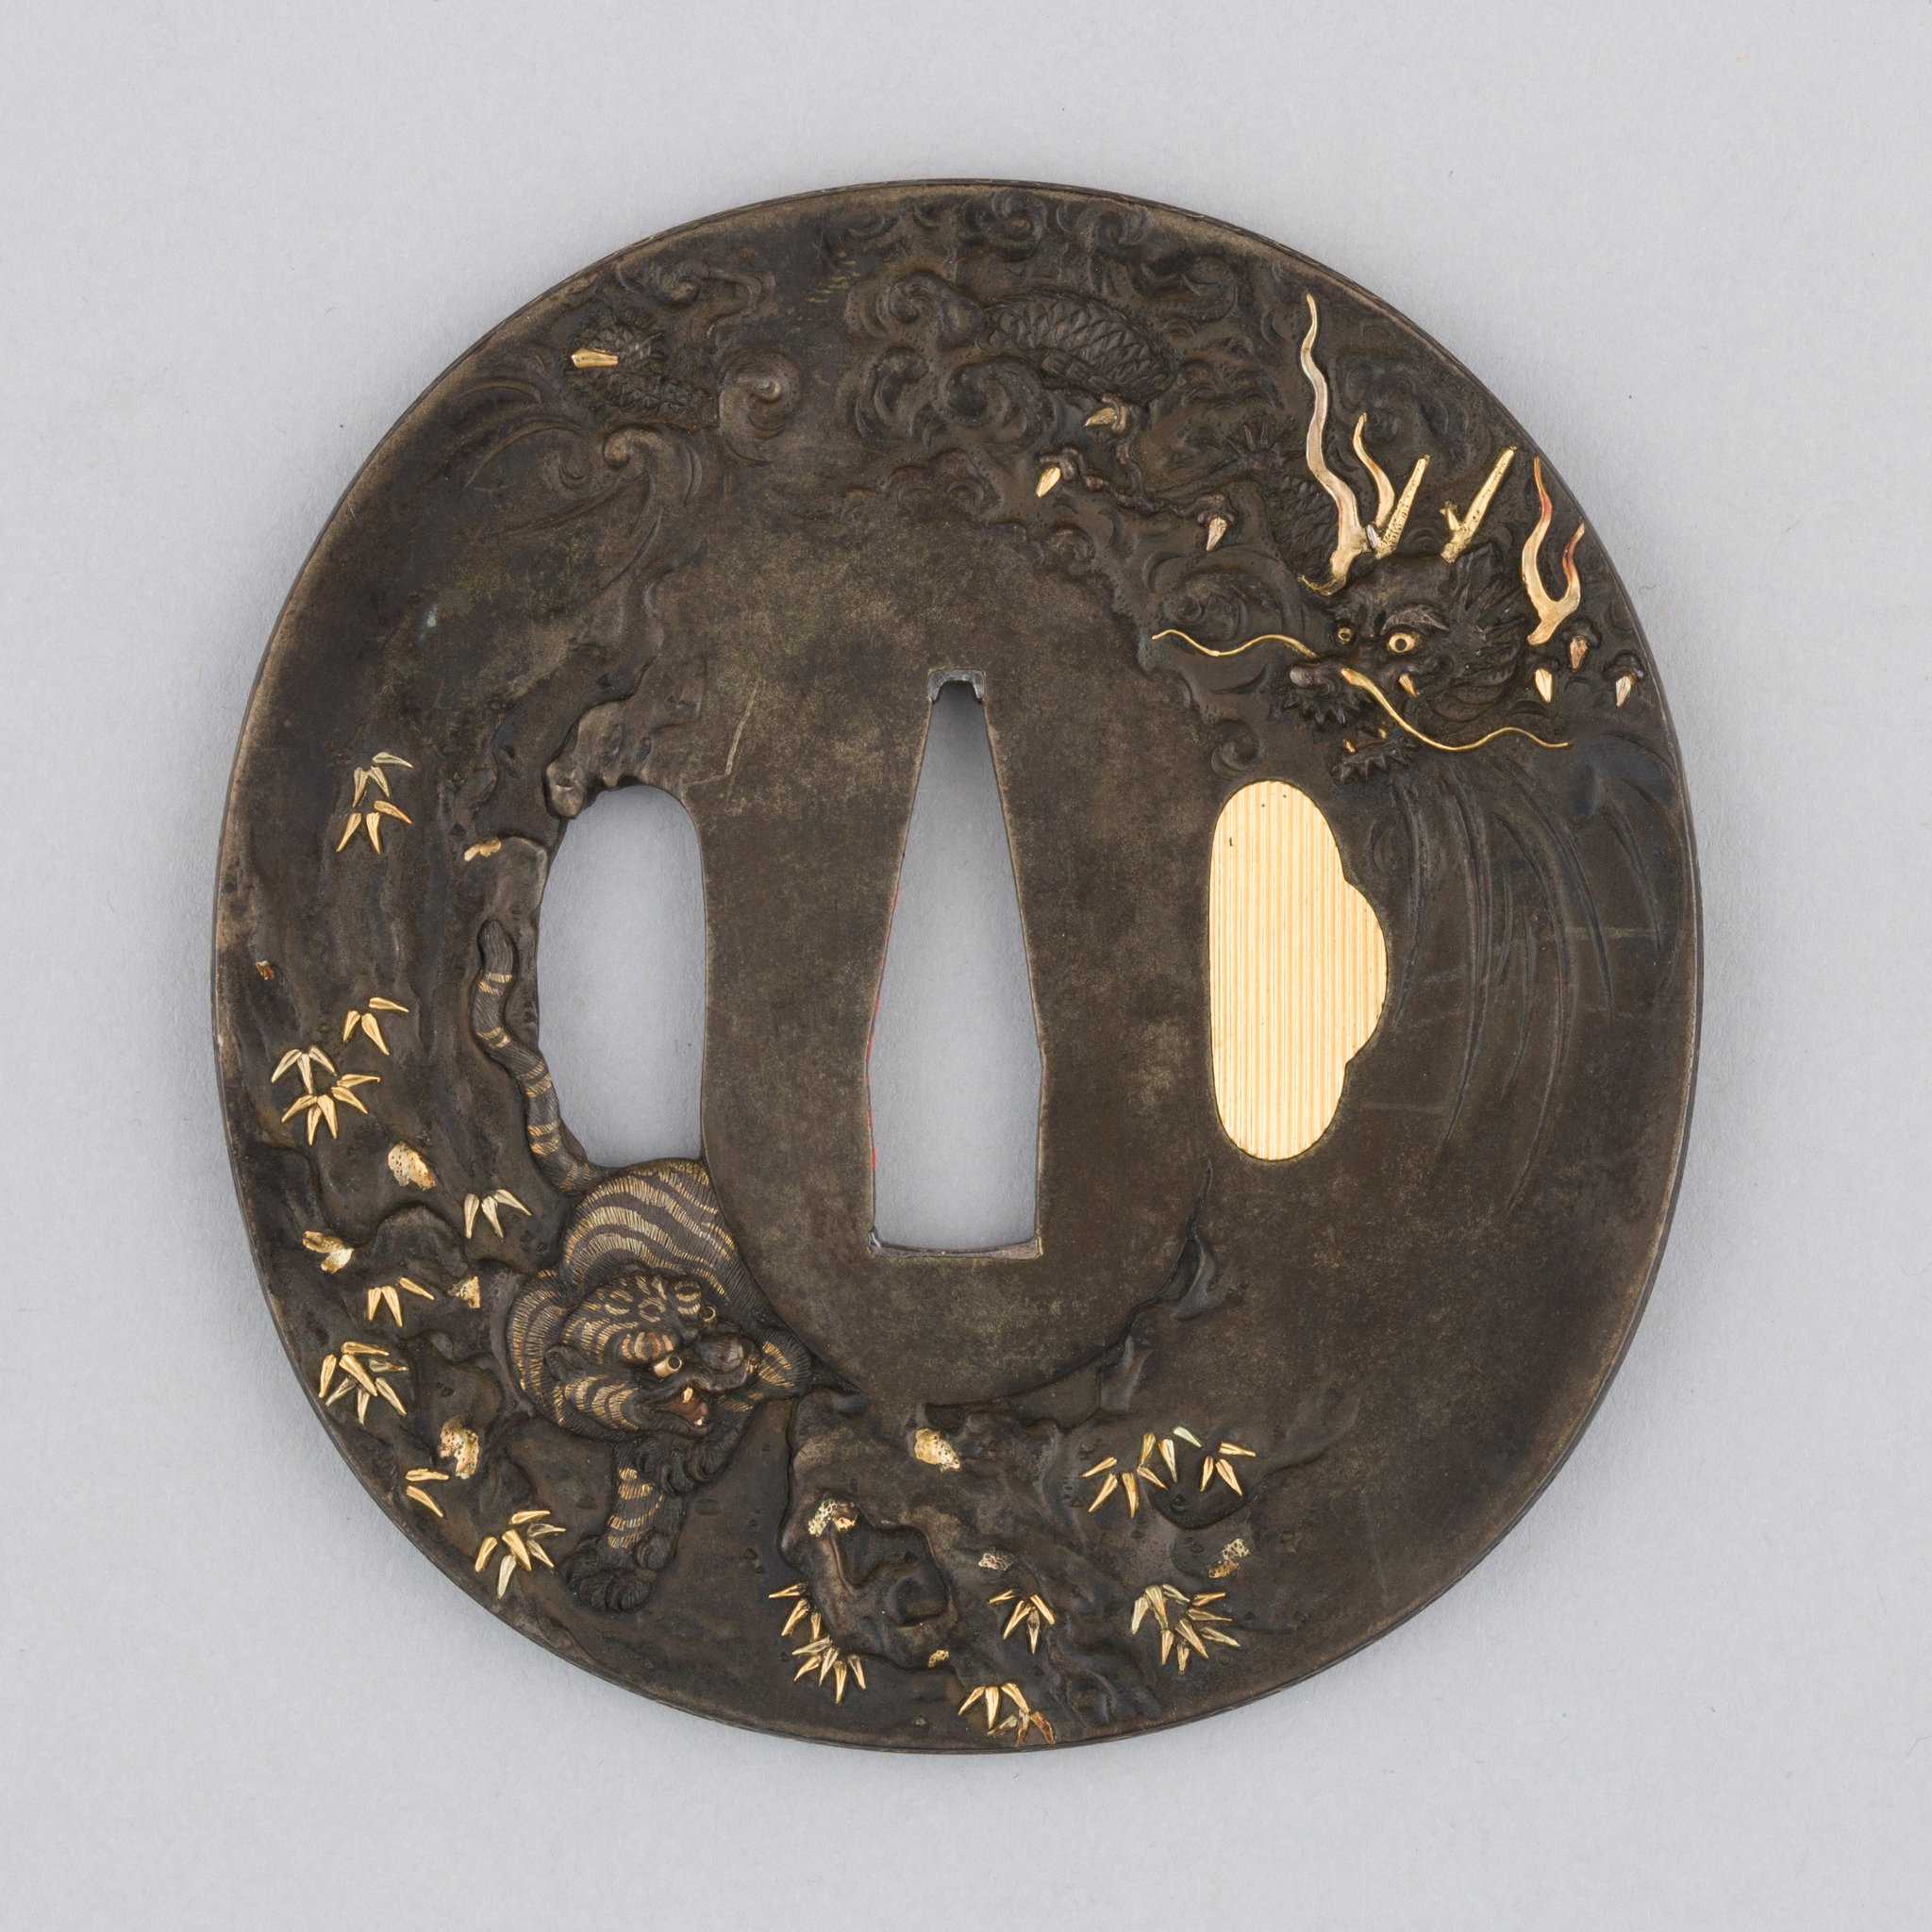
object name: sword guard tsuba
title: Sword Guard (Tsuba)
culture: japanese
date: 1801-1833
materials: copper, silver alloy, gold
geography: japan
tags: dragons,tigers